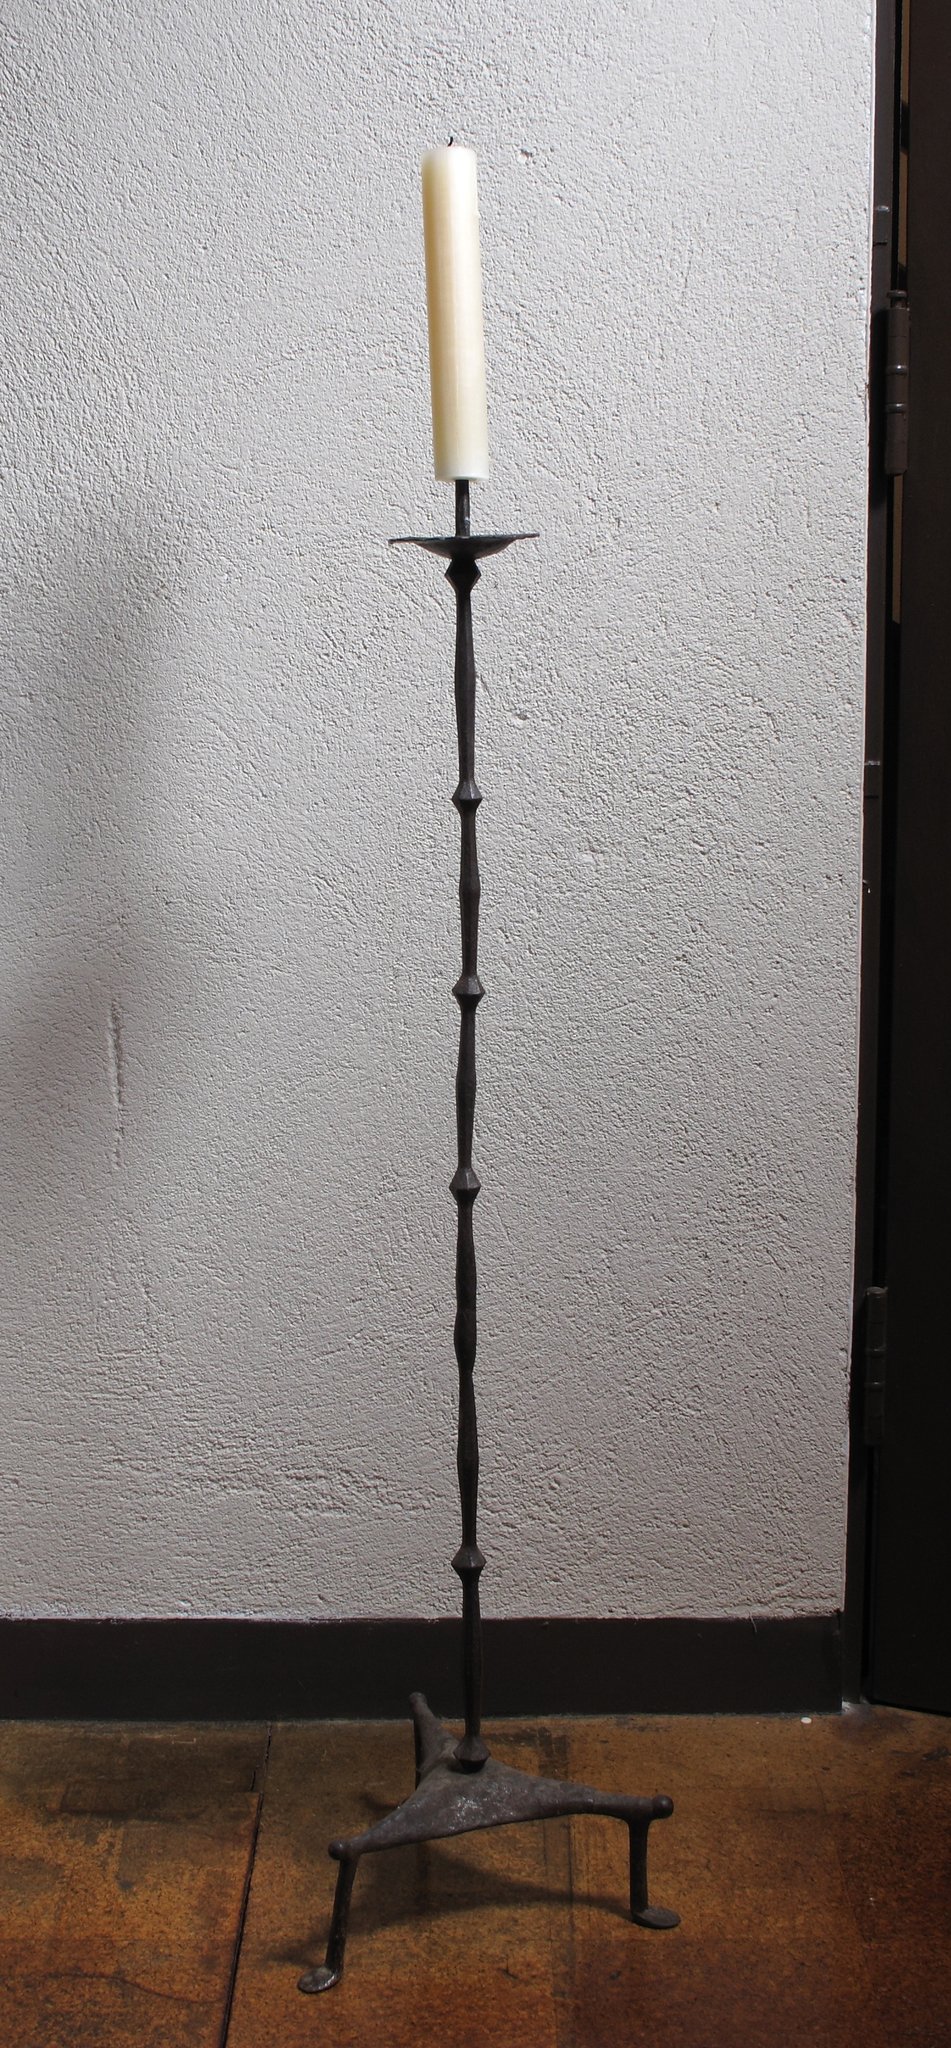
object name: candlestick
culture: european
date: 1401-1600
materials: iron